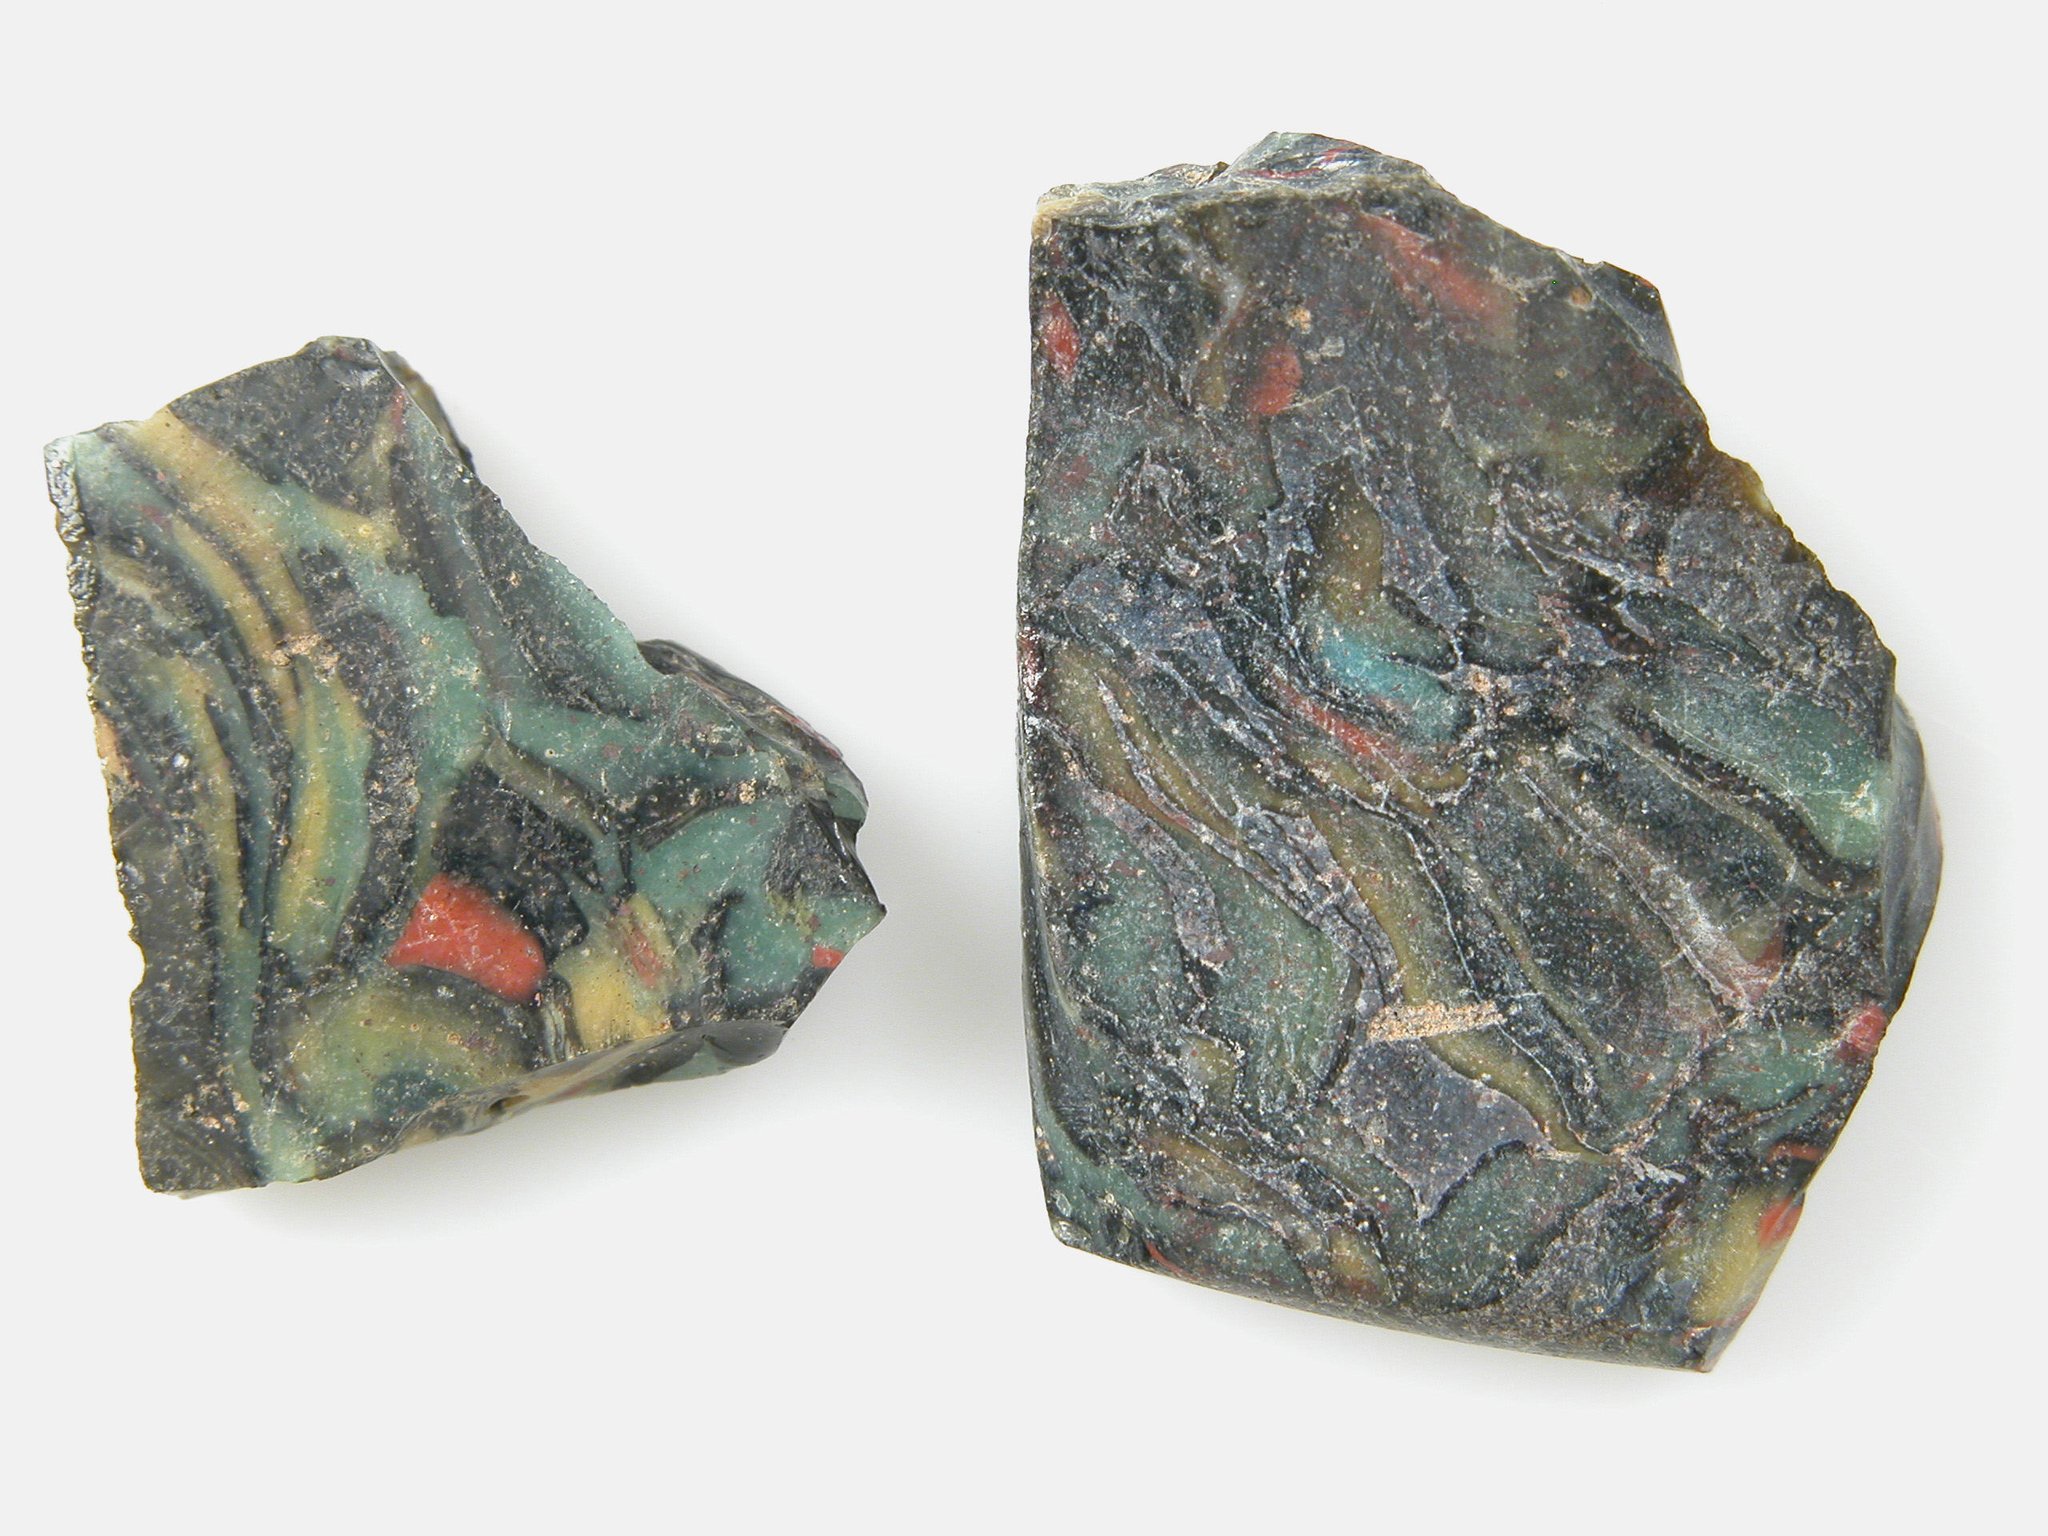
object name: fragment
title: Glass Fragments from a Vessel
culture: coptic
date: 301-433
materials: glass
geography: egypt